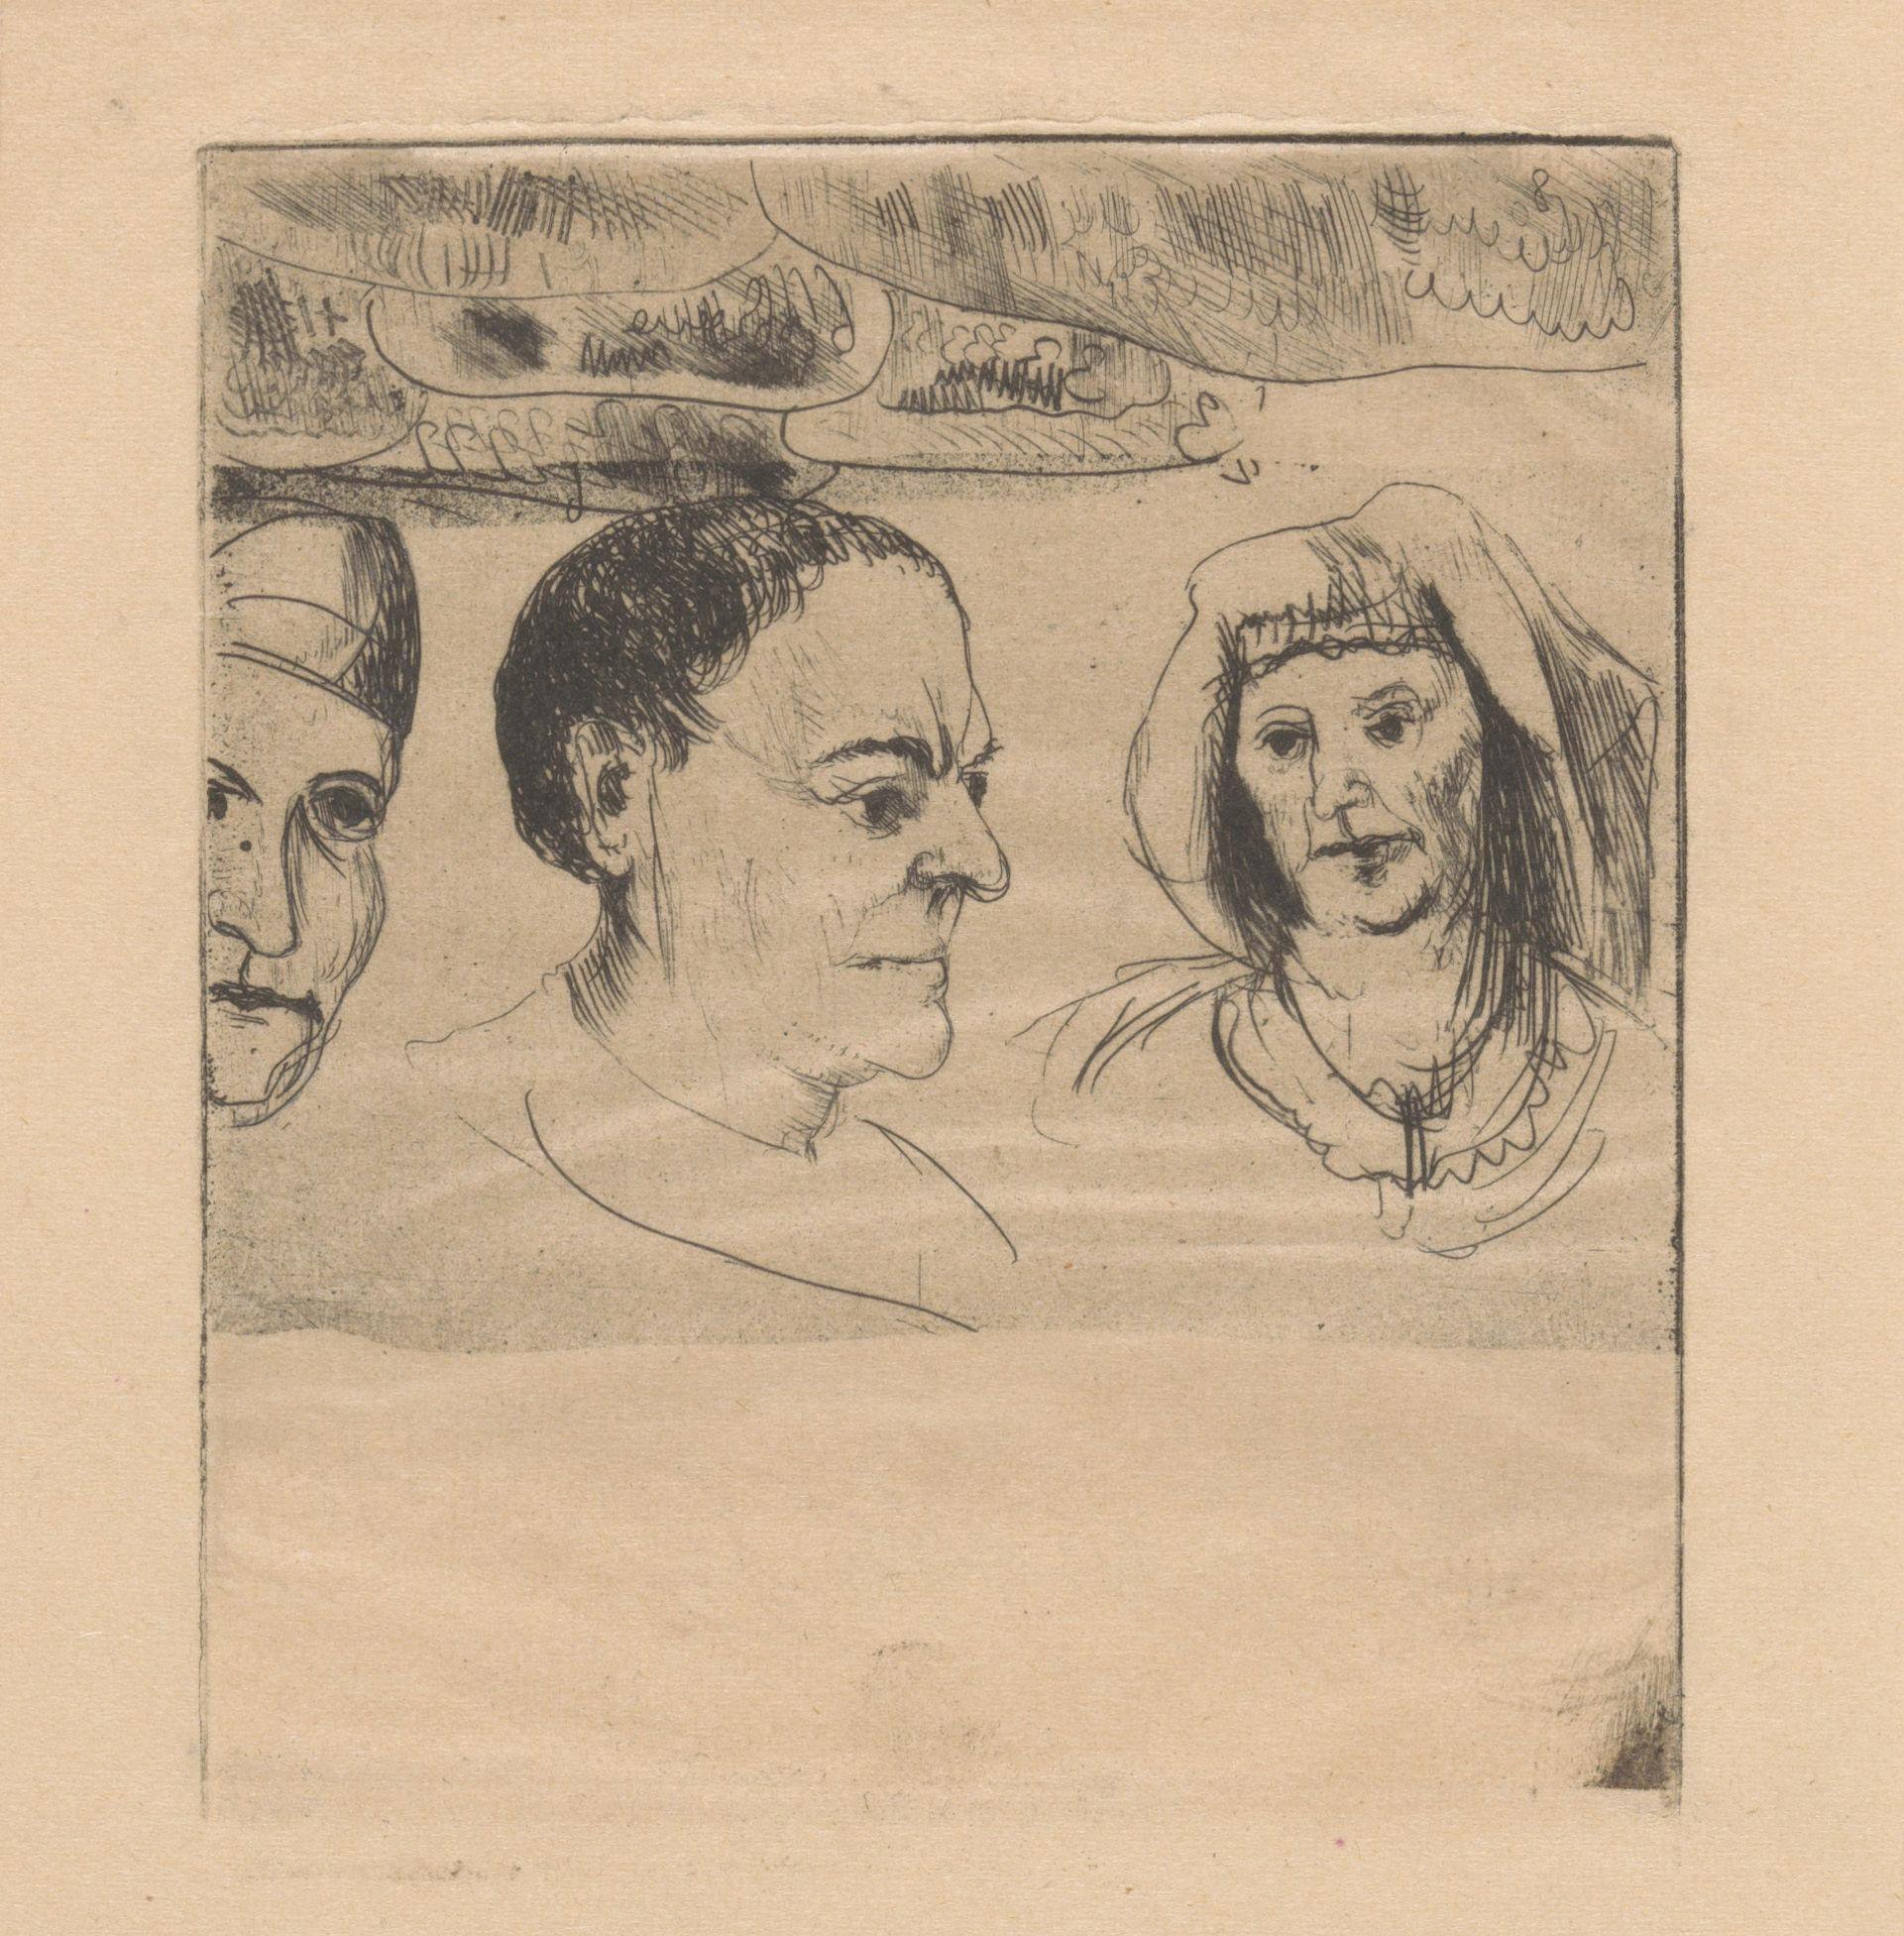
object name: print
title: Twee mannenhoofden en een vrouwenhoofd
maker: marius holleman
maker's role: draughtsman, print maker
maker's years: 1878-1926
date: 1904-1926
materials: paper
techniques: etching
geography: groningen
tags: clouds, veil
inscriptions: collector's mark: Lugt 2228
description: De vrouw draagt een sluier. Boven hun hoofden wolken.